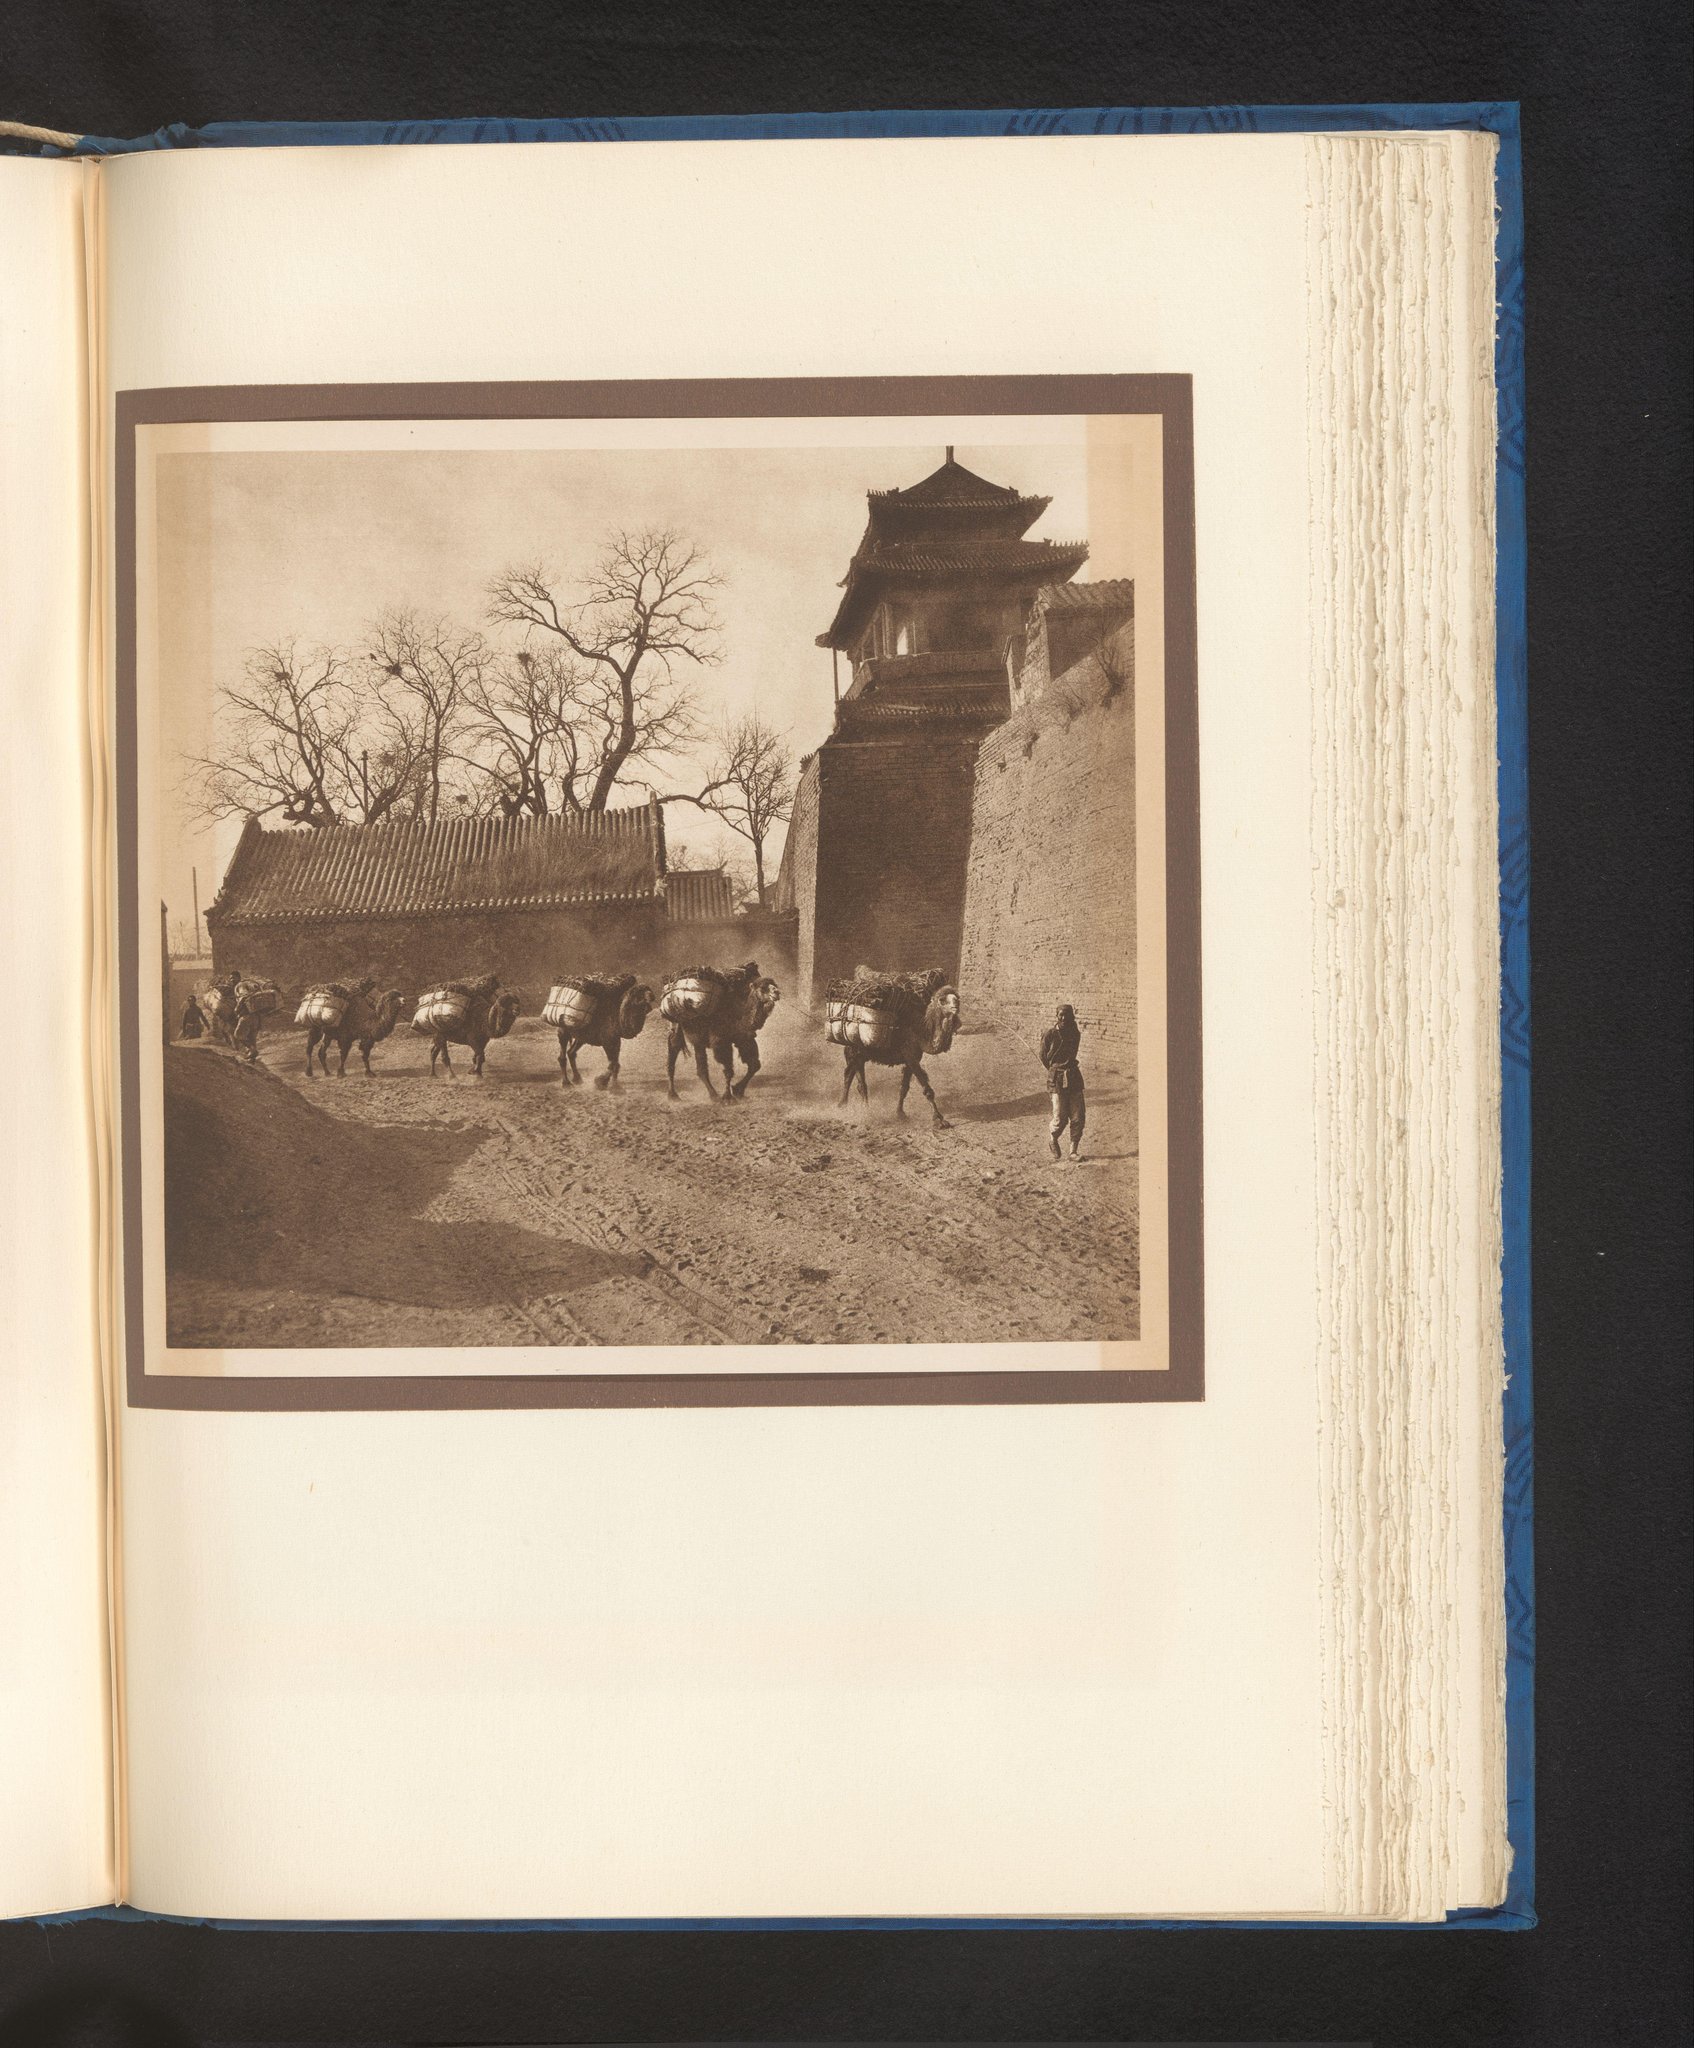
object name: page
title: Kamelen op een pad langs een gebouw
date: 1915-1920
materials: paper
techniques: rotogravure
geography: beijing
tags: hoofed animals: camel, road, path, civic architecture; edifices; dwellings